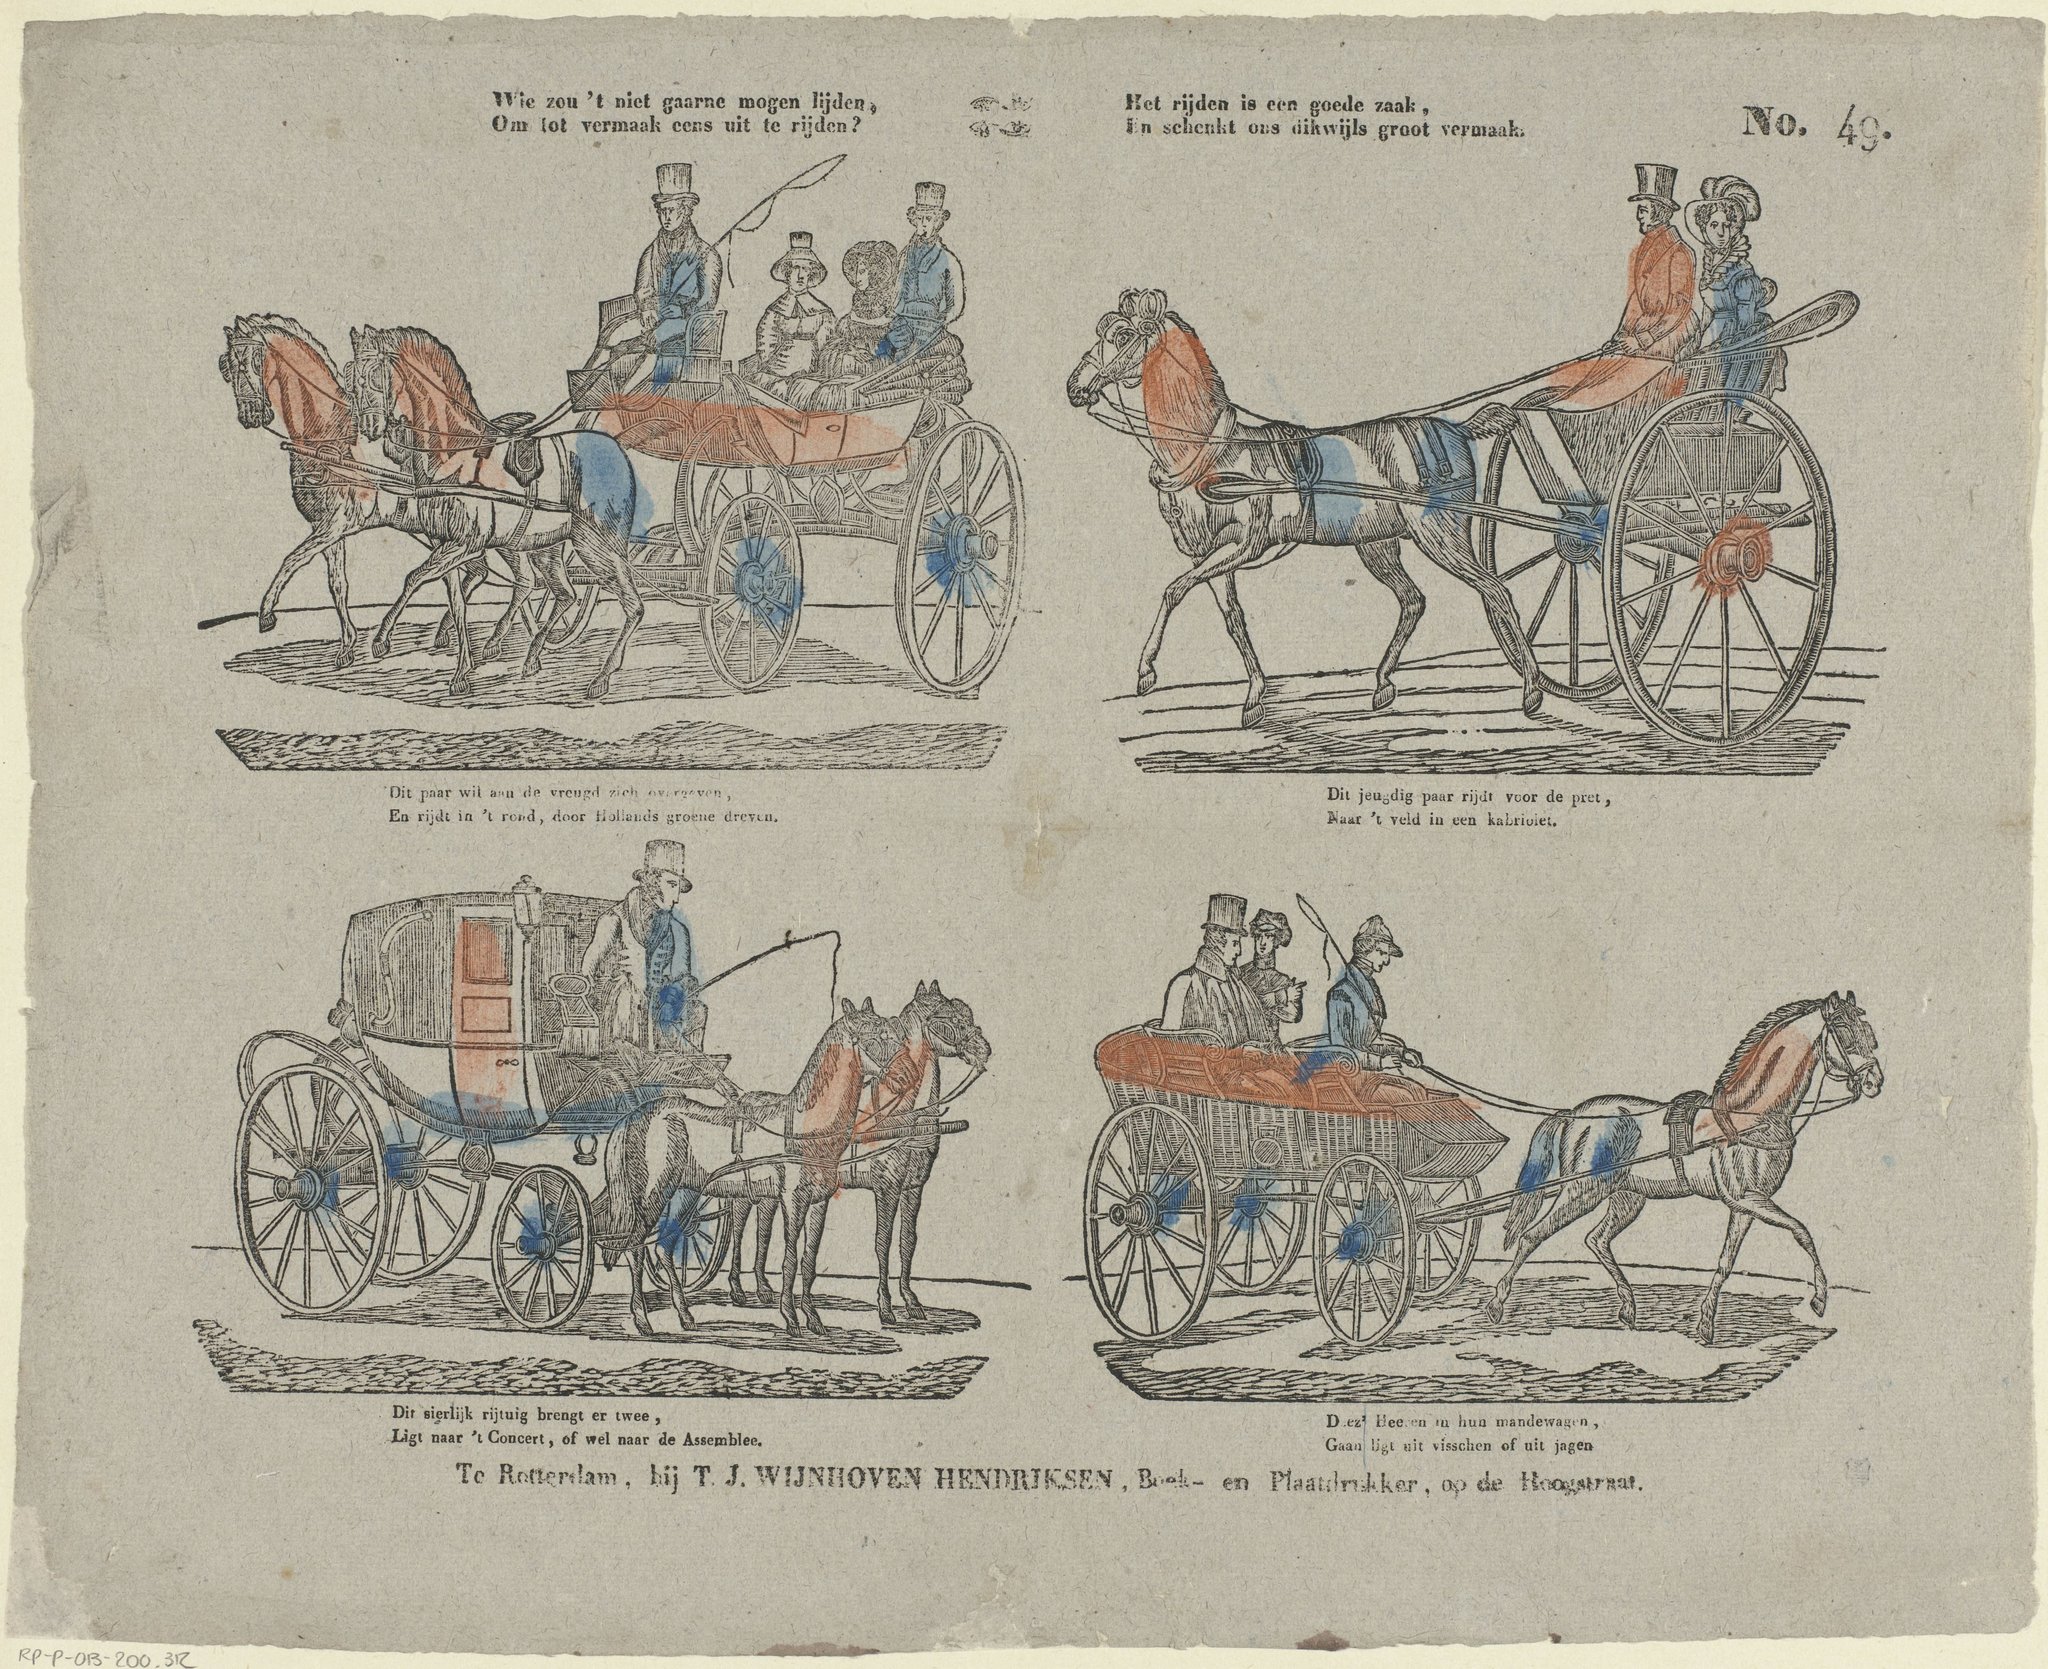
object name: print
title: Wie zou 't niet gaarne mogen lijden, / Om tot vermaak eens uit te rijden? / Het rijden is een goede zaak, / En schenkt ons dikwijls groot vermaak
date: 1832-1850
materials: paper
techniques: colour, letterpress printing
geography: rotterdam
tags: four-wheeled, animal-drawn vehicle, e.g.: cab, carriage, coach, two-wheeled vehicle drawn by one animal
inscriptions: collector's mark: Lugt 2760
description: Blad met 4 voorstellingen van rijtuigen getrokken door paarden. Onder elke afbeelding een tweeregelig vers. Genummerd rechtsboven: No. 49.